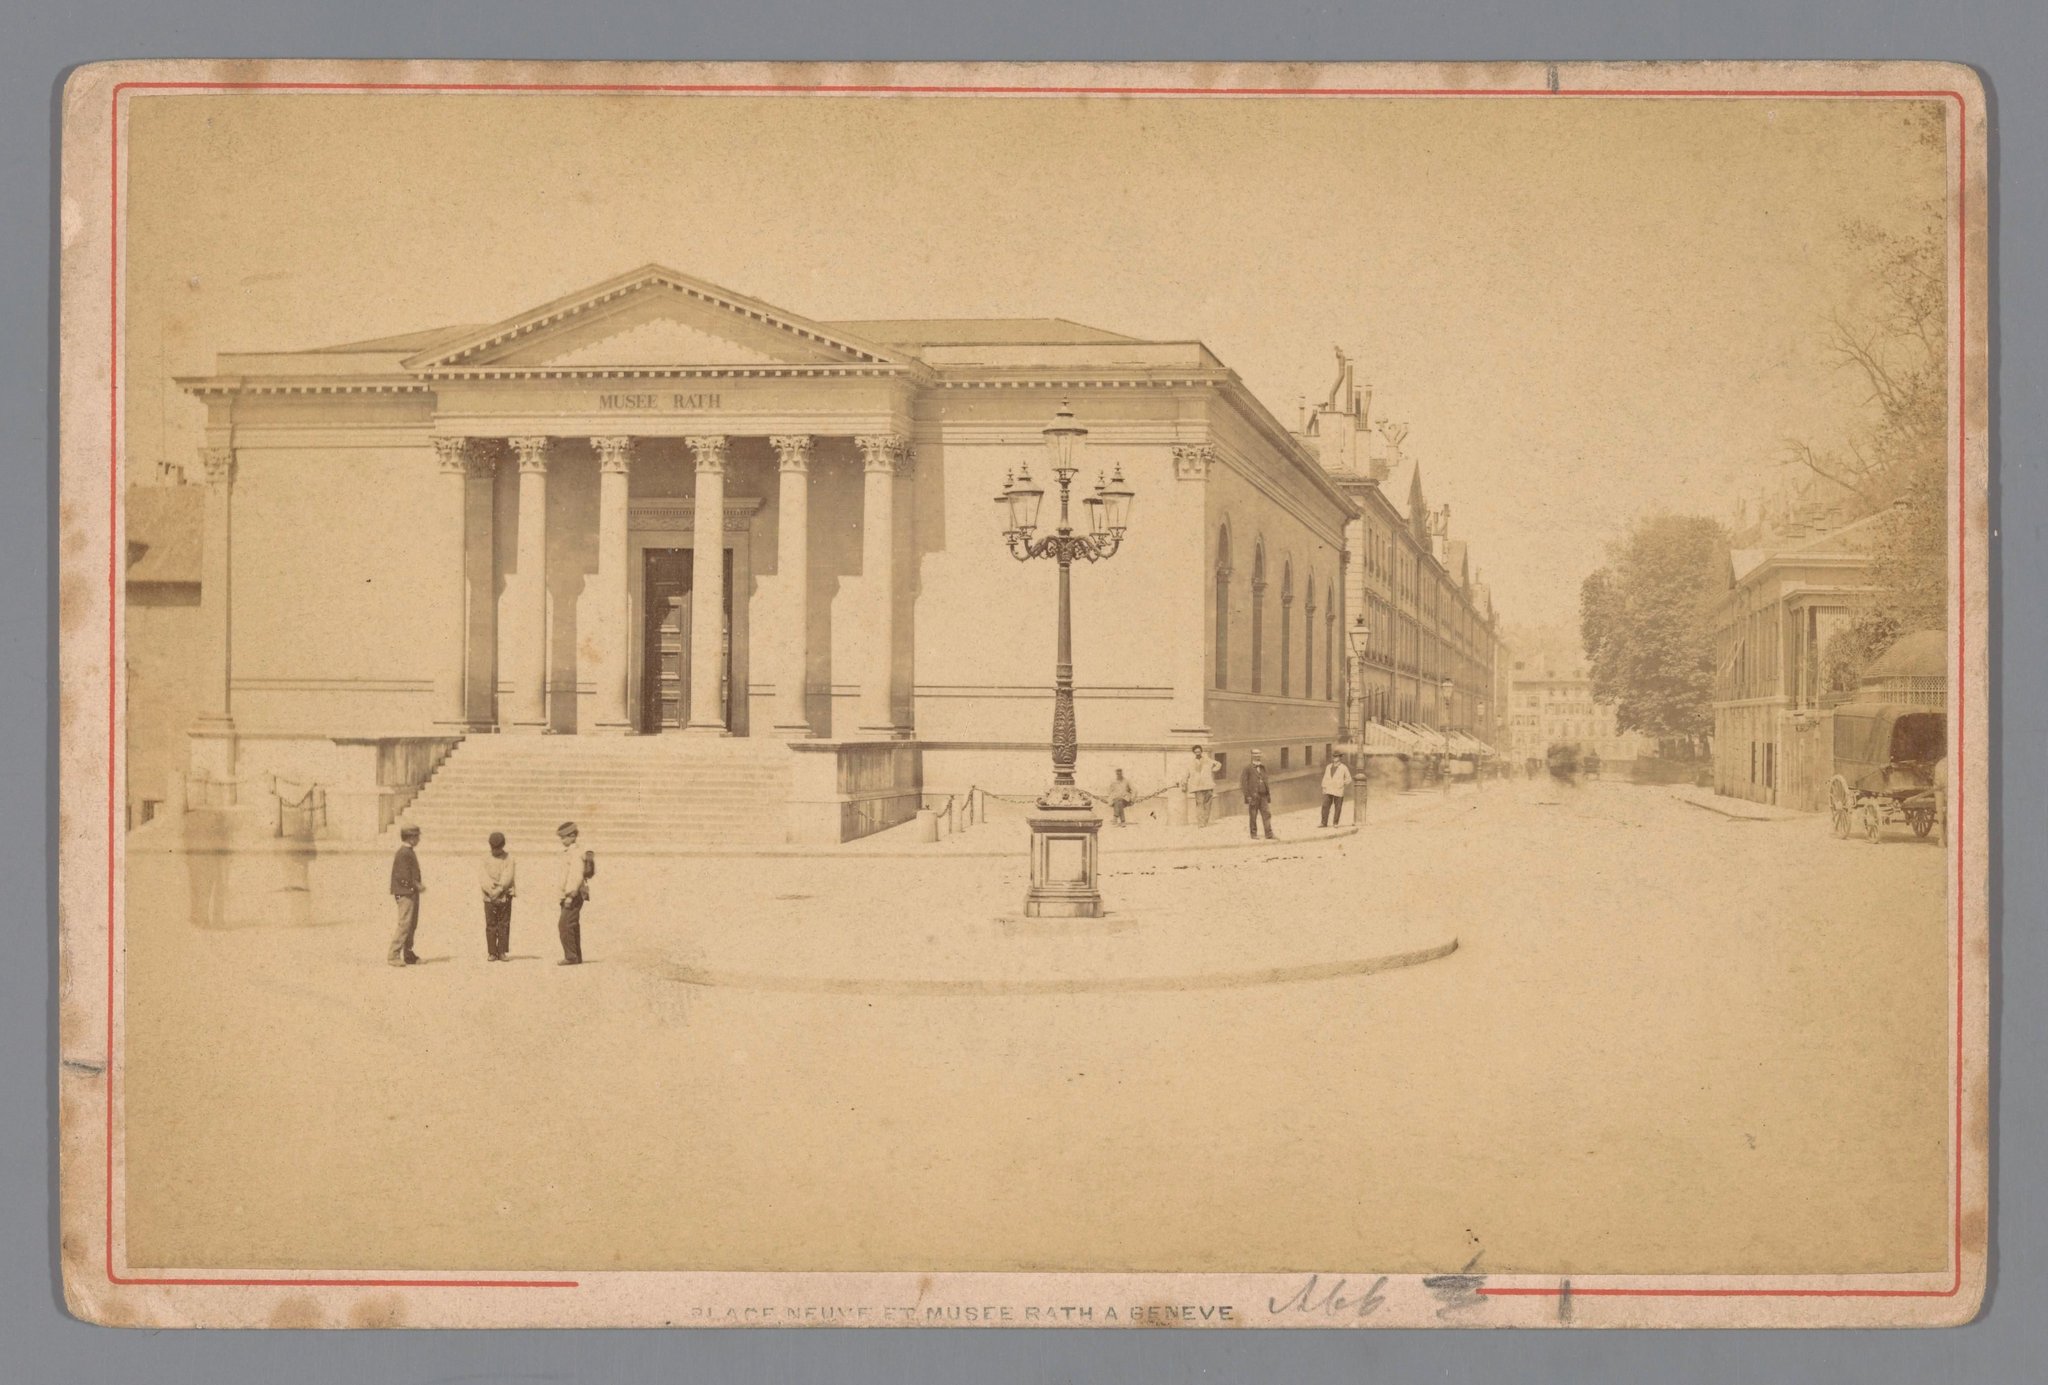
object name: photograph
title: Gezicht op Place Neuve en Musée Rath in Genève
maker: garcin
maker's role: fotograaf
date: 1880-1920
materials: cardboard, photographic support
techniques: albumen print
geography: geneva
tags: permanent exhibition, museum, village square, place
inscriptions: inscription: ‘l II [...] ample of week [...] a [...] Museum at geneva’, number: ‘m6’, number: ‘42715’, name: ‘F. Munster-Rochevalier Papeterie 86, Rue du Rhône, Genève’